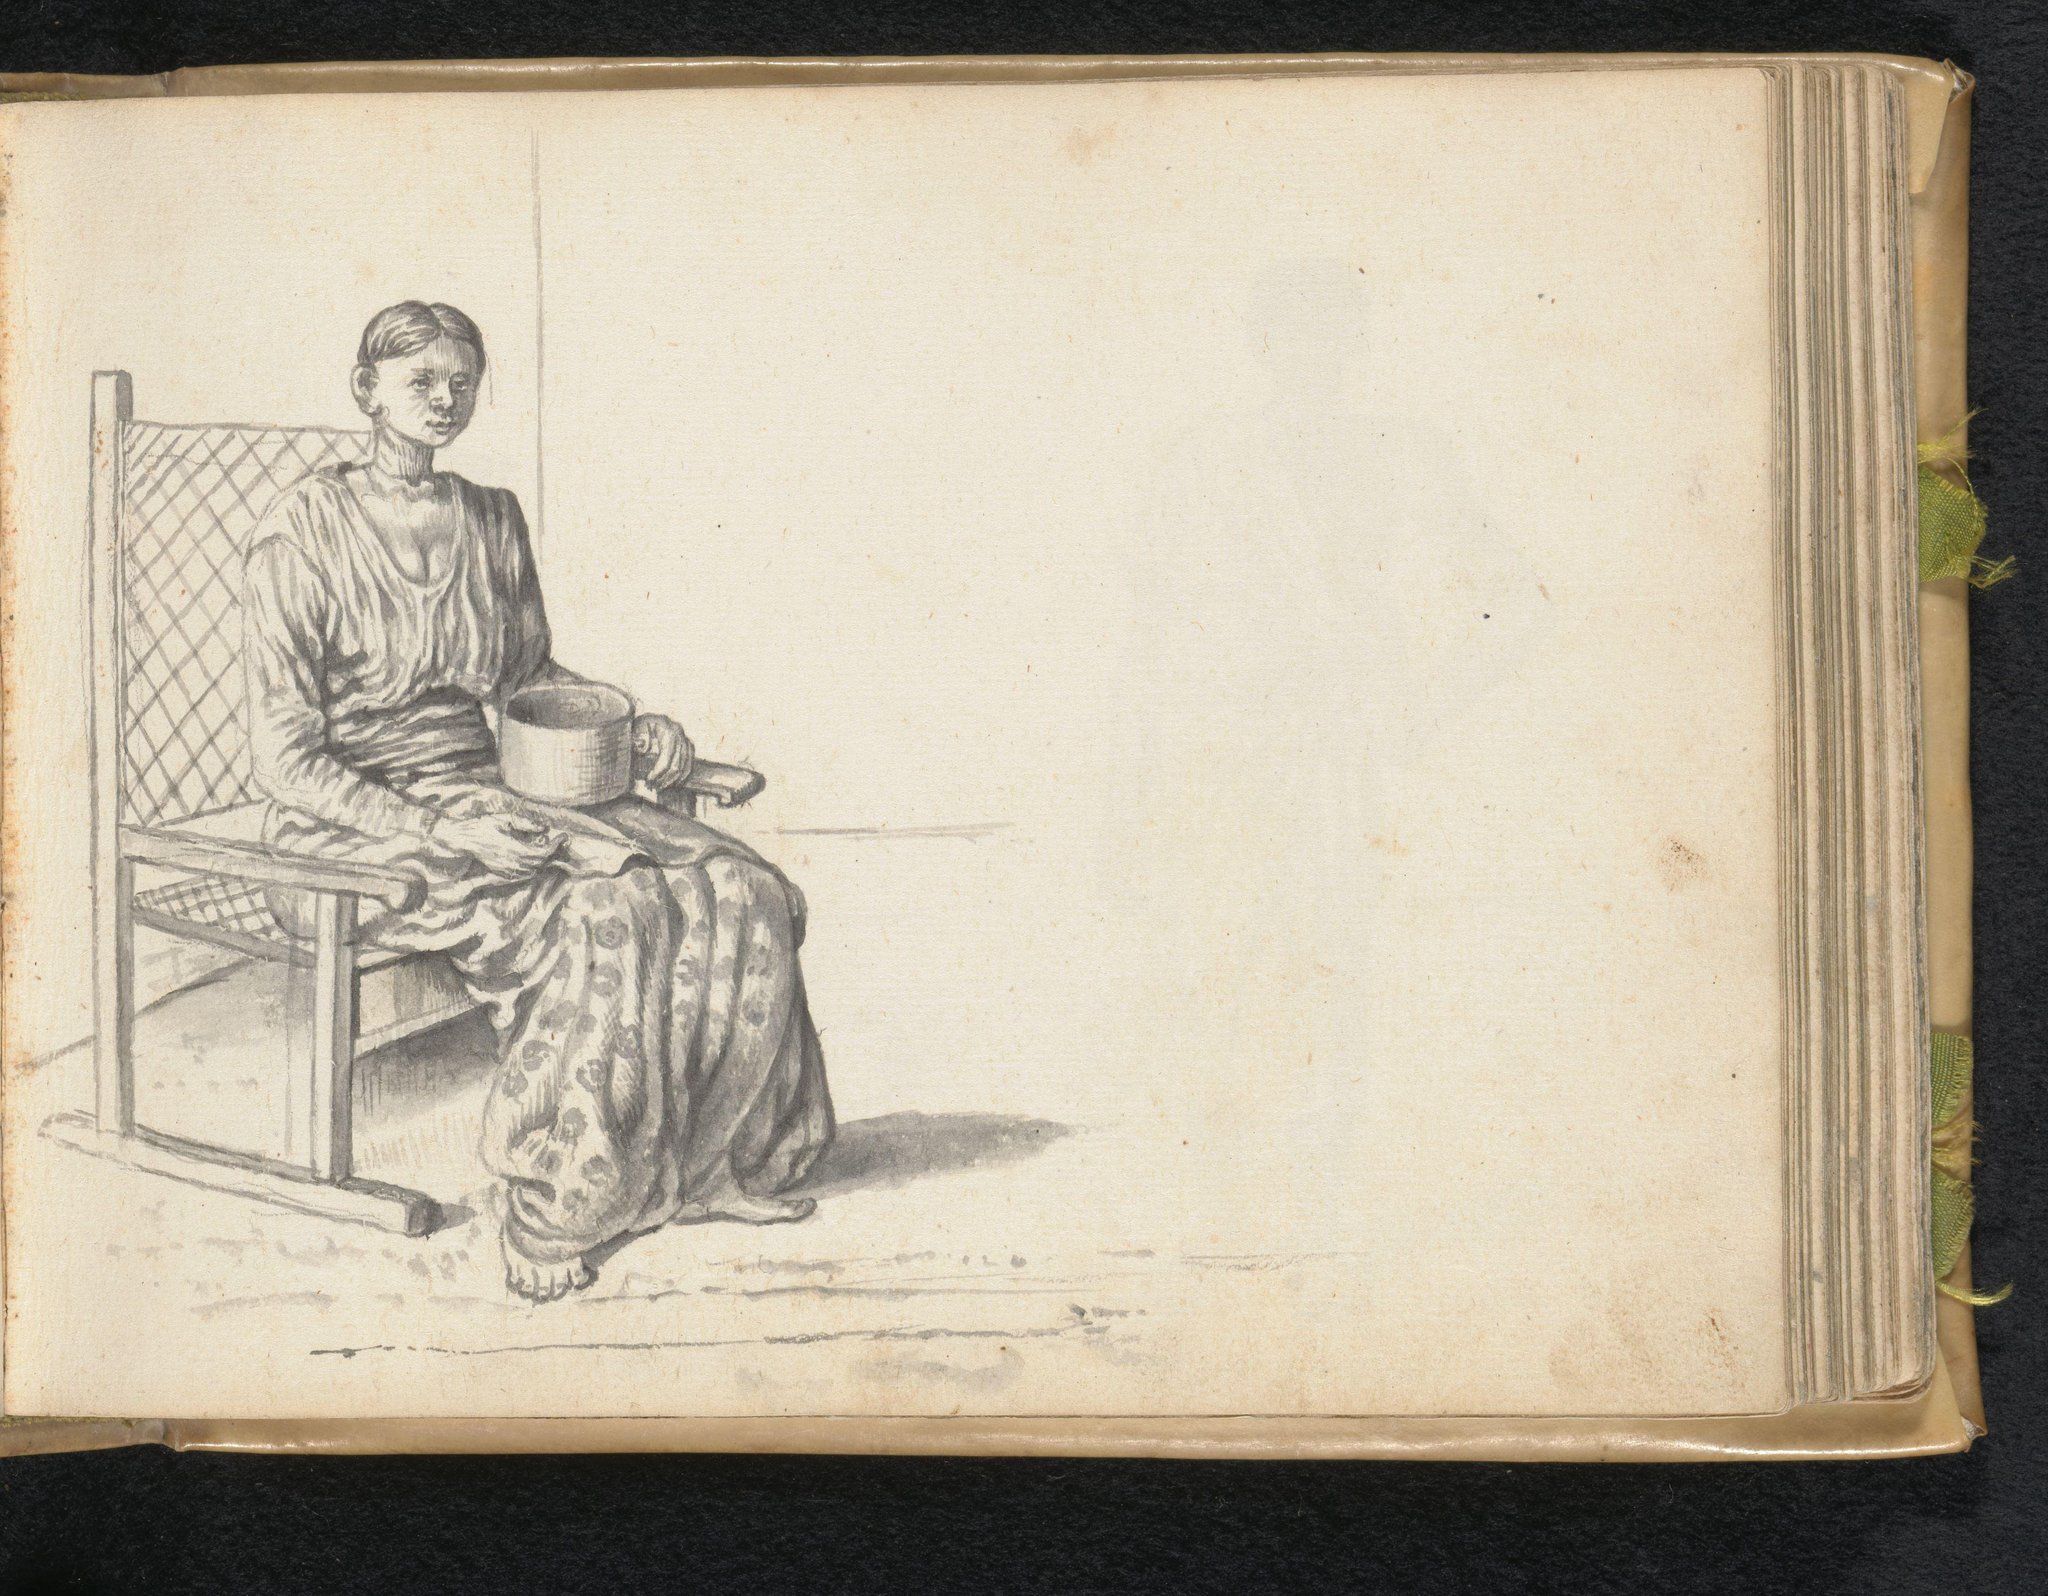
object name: sketchbook leaf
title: A woman inside a house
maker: esaias boursse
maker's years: 1631-1672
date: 1662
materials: ink, paper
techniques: brush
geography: sri lanka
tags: rocking-chair, eurasion, half-caste, skirt (with name), clothing for the upper part of the body (with name), styles of hairdress (with name) - ~women, interior of the house, sri lanka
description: In een ruimte met strakke witte wanden zit een Euraziatische vrouw op een houten leunstoel. Ze draagt een lange wikkelrok (redda) van stof met een bloemetjesmotief, en een wijde Portugese bloes met lange mouwen (hatte). Het haar met een scheiding in het midden is strak naar achter gekamd in een wrong (condé). Haar rechterhand ligt op haar schoot, naast een pan die ze met haar linkerhand vast houdt. De stoel is een eenvoudig Portugees model met geweven rieten of rotan zitting en rug. Het lijkt een schommelstoel te zijn. De pan zonder handvatten of steel is waarschijnlijk van messing of koper. Blad 20 uit een schetsboek met 117 bladen.